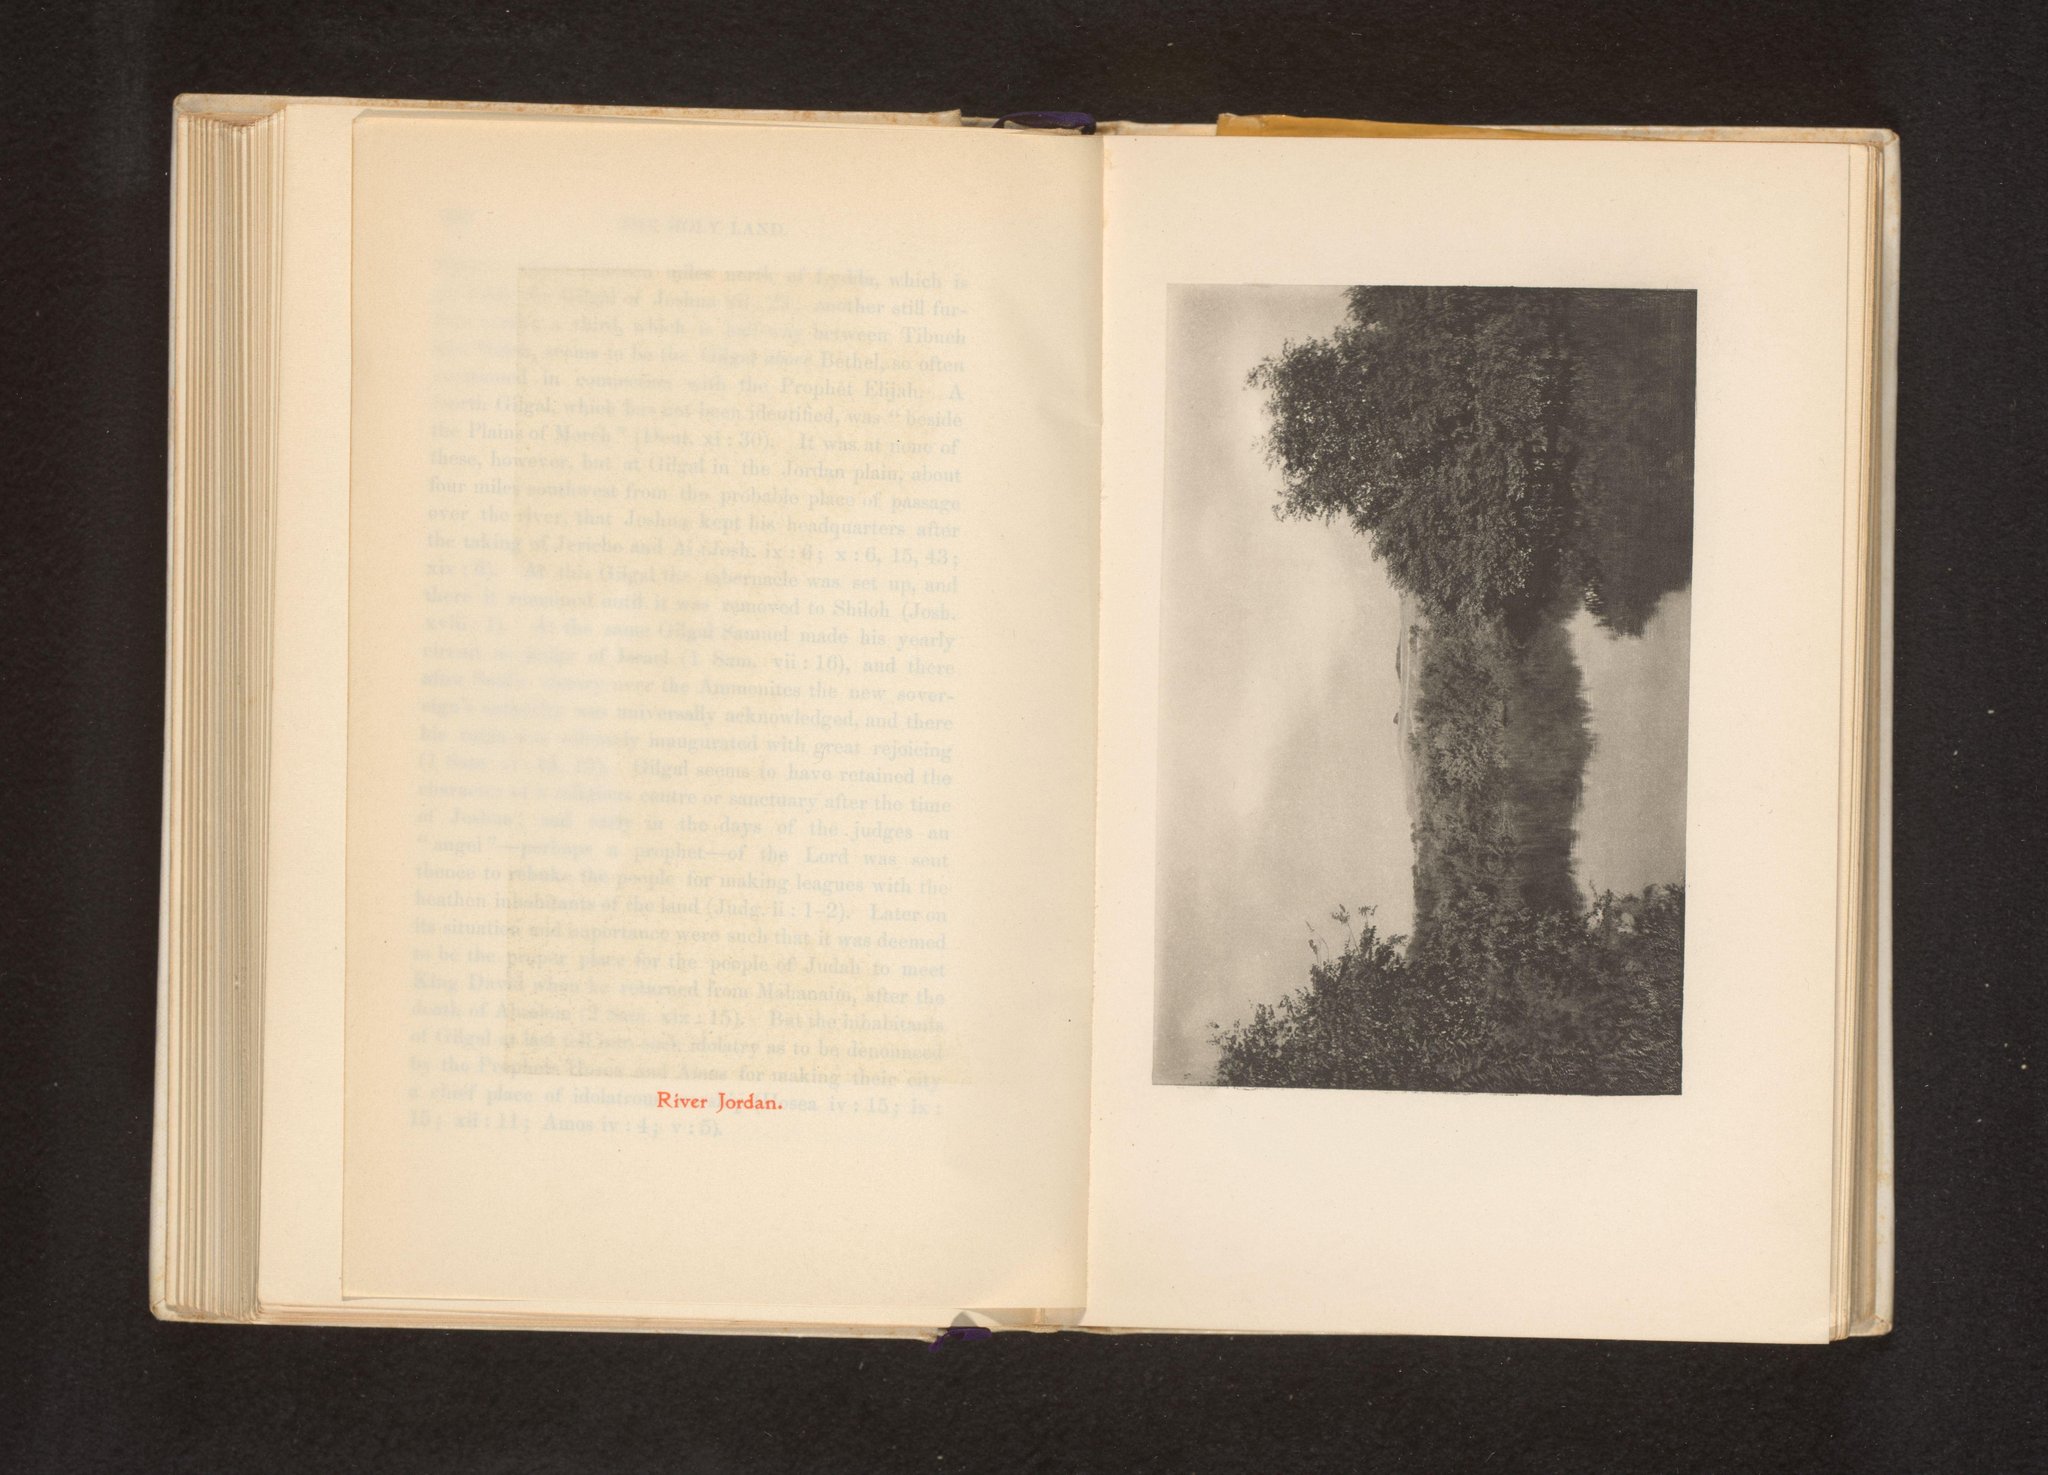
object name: photomechanical print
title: Gezicht op de Jordaan te Palestina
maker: Anonymous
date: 1890-1900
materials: paper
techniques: photoaquatint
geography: palestine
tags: river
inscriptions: title: ‘River Jordan.’